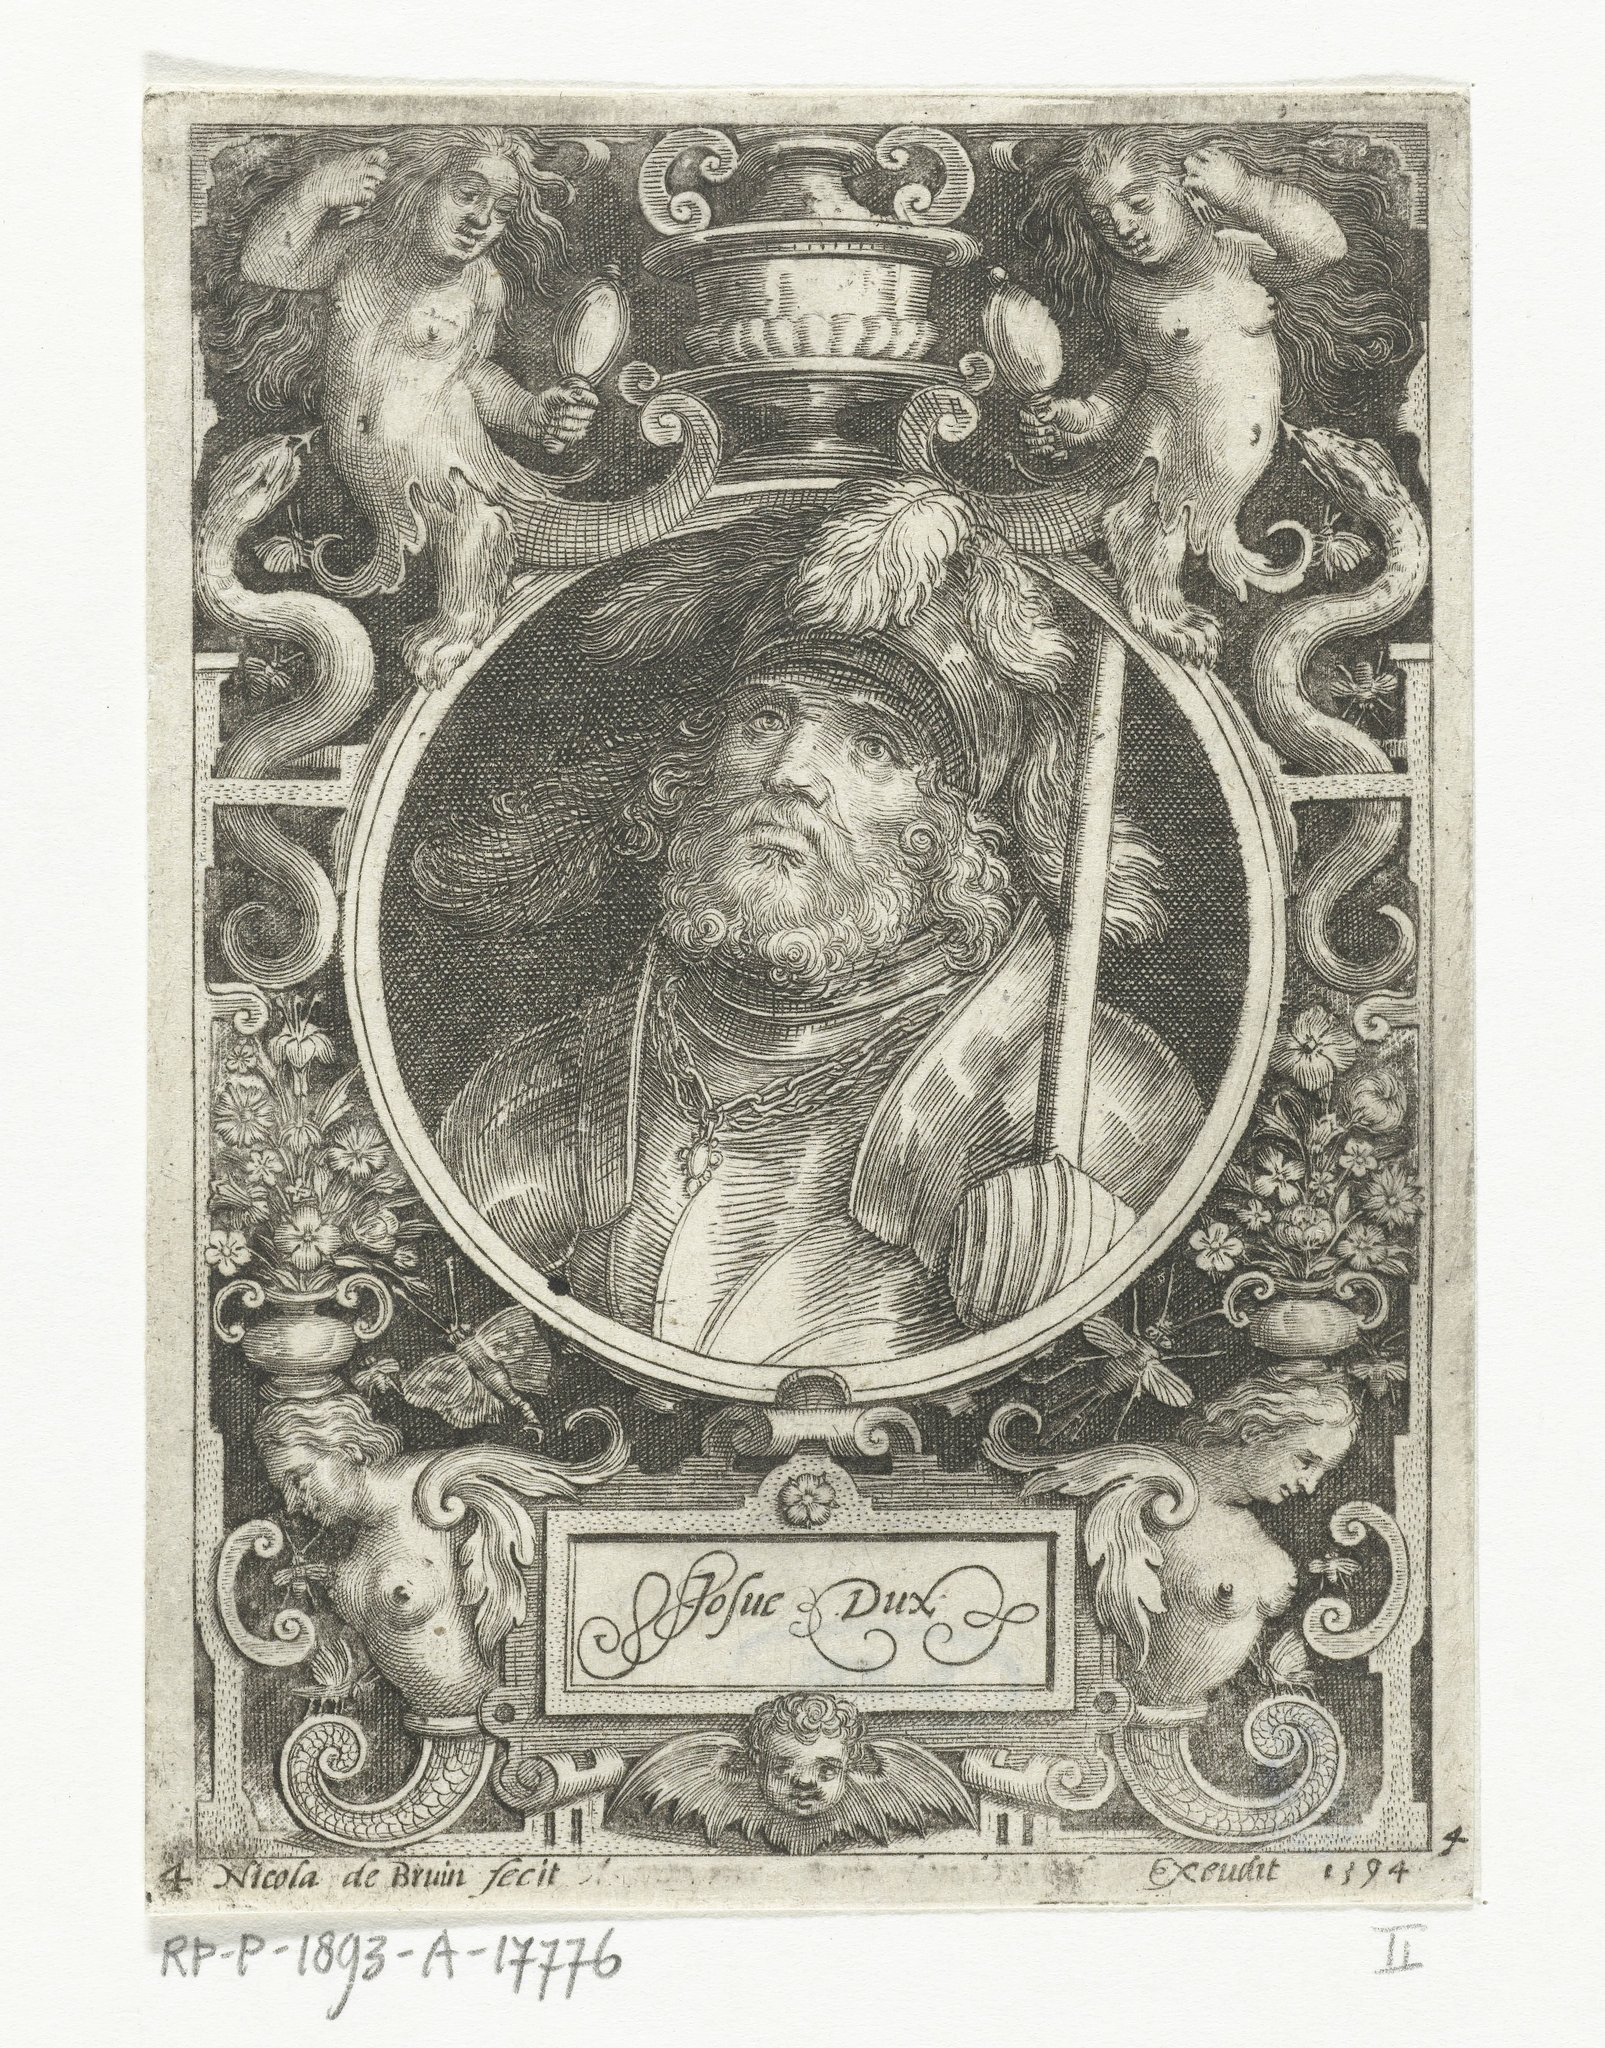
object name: print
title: Portret van Jozua in medaillon binnen rechthoekige omlijsting met ornamenten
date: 1594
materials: paper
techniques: engraving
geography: netherlands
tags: joshua (one of the nine worthies)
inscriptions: collector's mark: Lugt 2228, collector's mark: Lugt 577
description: Portret van Julius Caesar als veldheer uit de Oudheid in medaillon binnen rechthoekige omlijsting met ornamenten in de vorm van slangen en fantasiewezens.